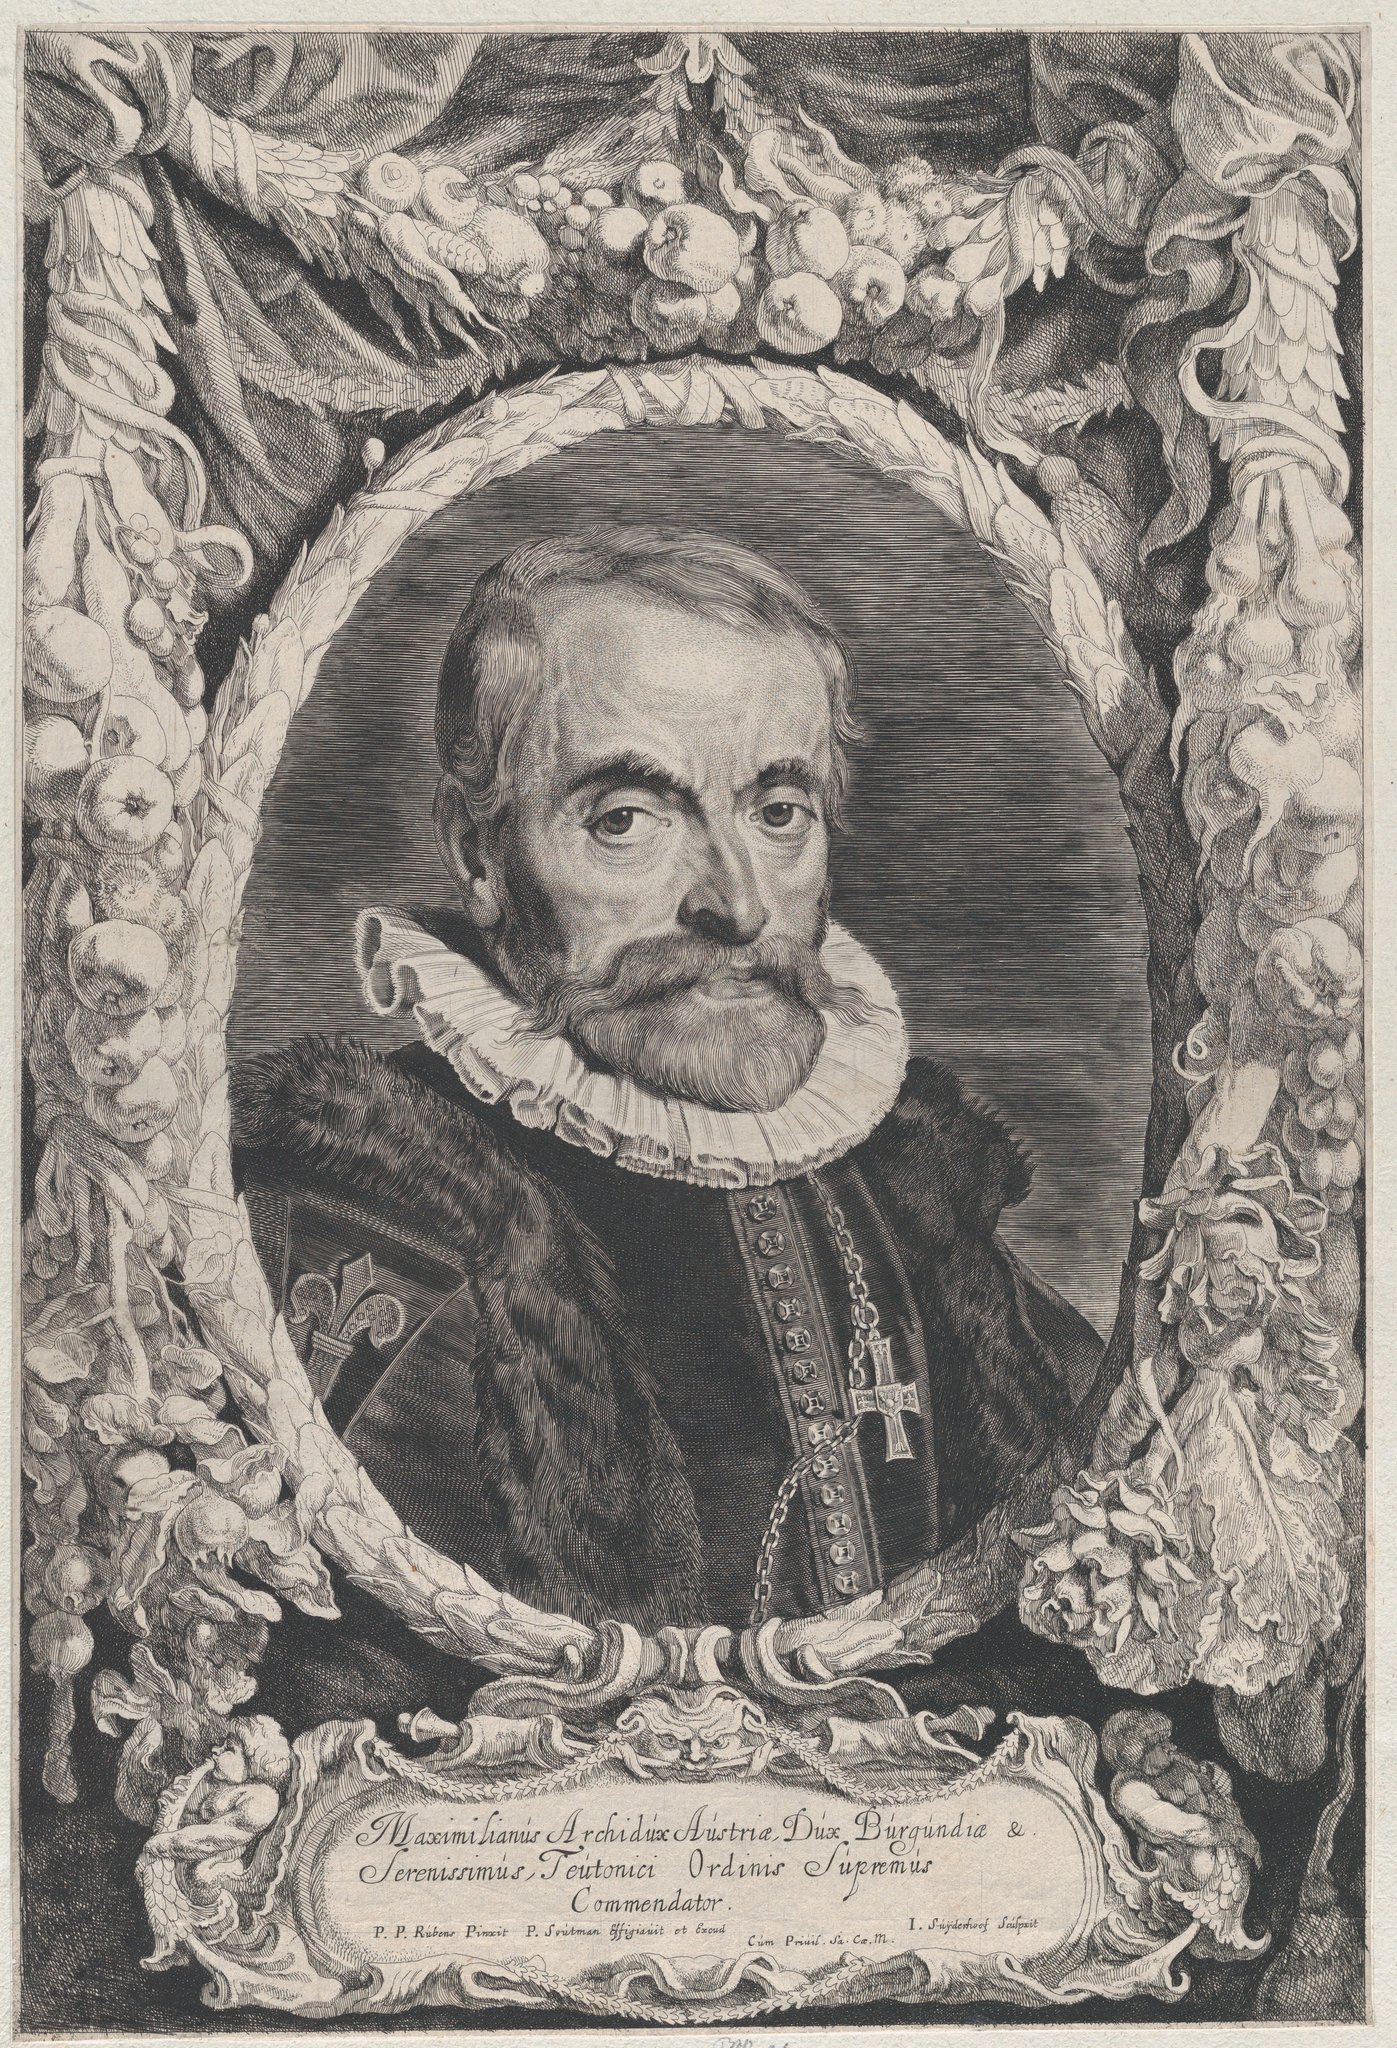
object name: print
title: Portrait of Maximilian III, Archduke of Austria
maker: jonas suyderhoef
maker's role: artist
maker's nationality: dutch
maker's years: 1613-1686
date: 1650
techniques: engraving, etching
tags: men,portraits